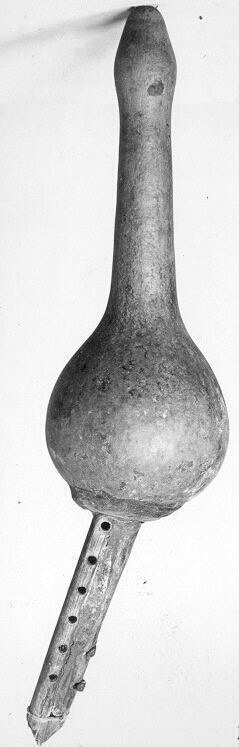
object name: pūngī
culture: indian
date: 1867-1900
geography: india